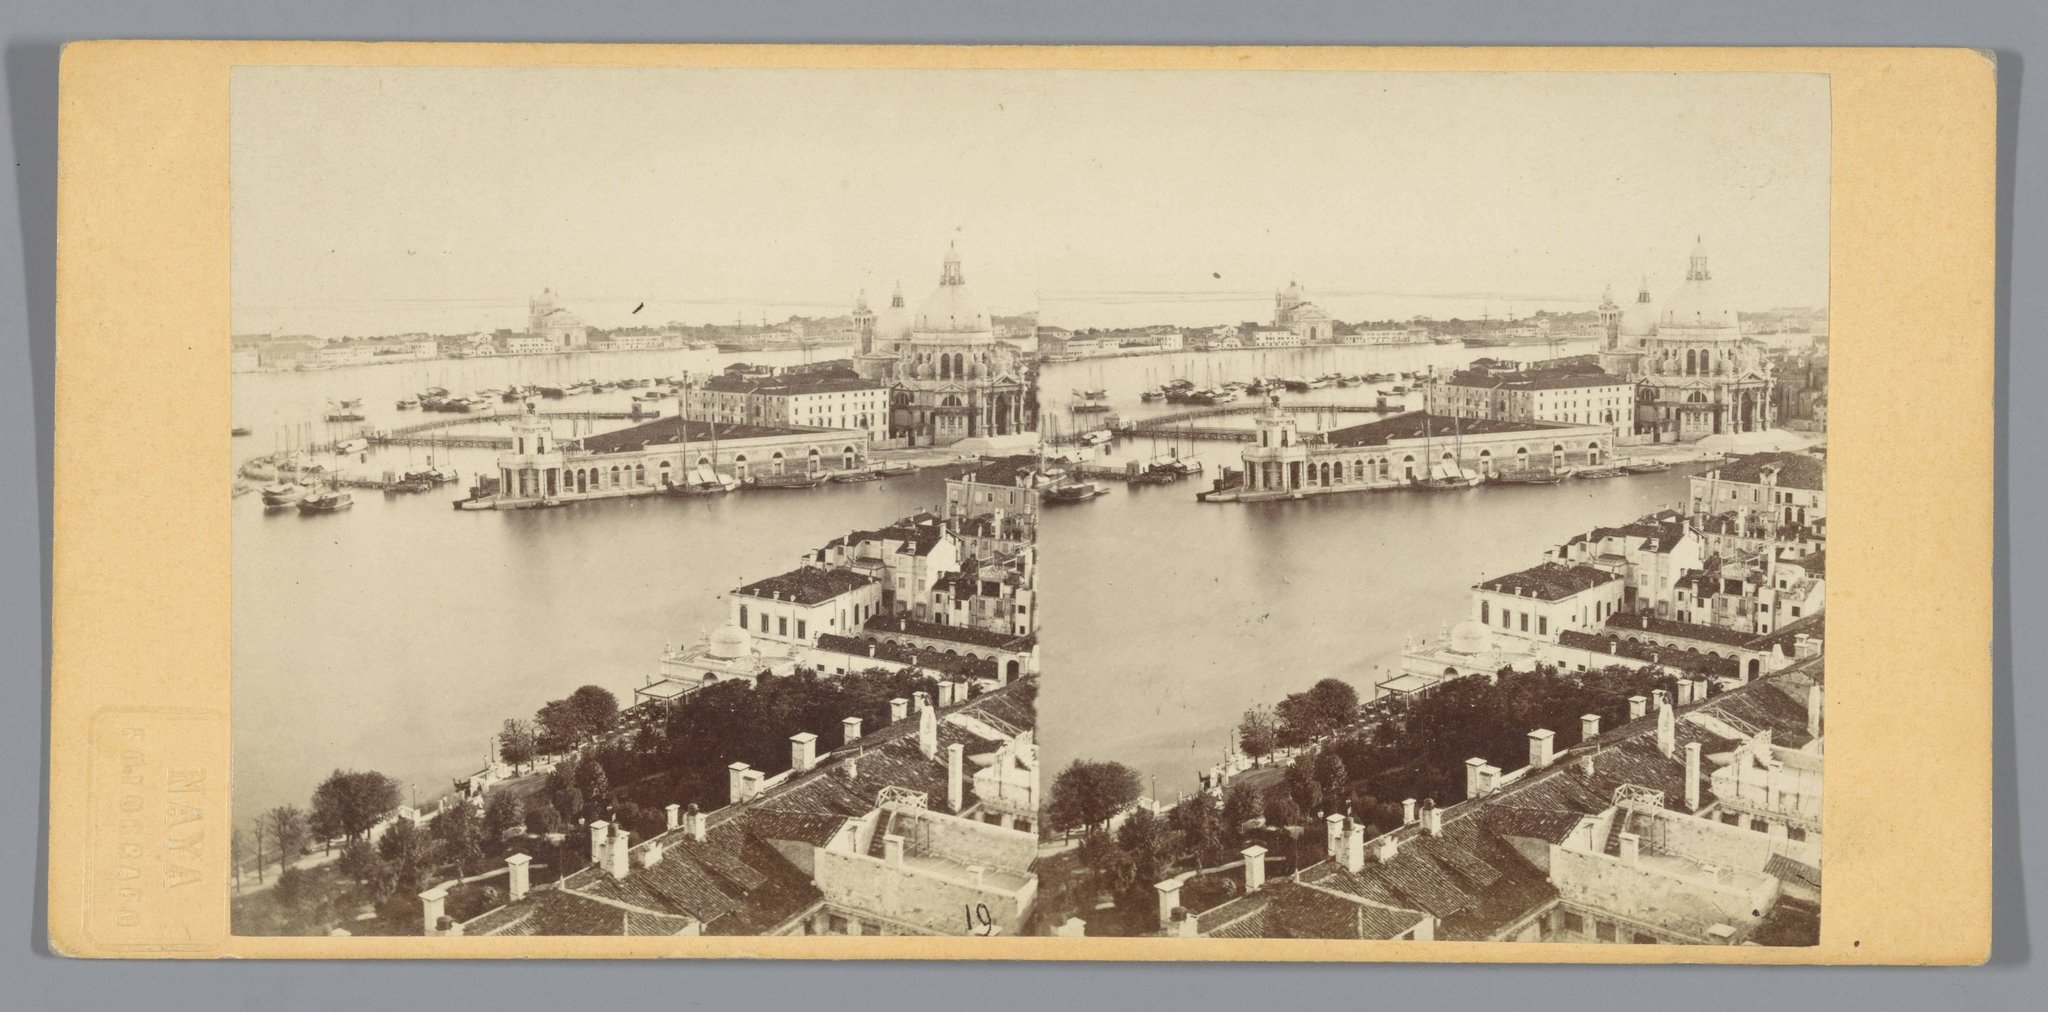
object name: stereograph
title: Gezicht op Venetië vanuit Campanile van Venetië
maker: carlo naya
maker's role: fotograaf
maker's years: 1816-1882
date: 1850-1880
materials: cardboard, photographic support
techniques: albumen print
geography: venice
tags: city-view, and landscape with man-made constructions, venice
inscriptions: number: ‘19’, inscription: ‘Venezia, Panorama dal Campanile di S. Marco Ansicht von Markus Thurn’